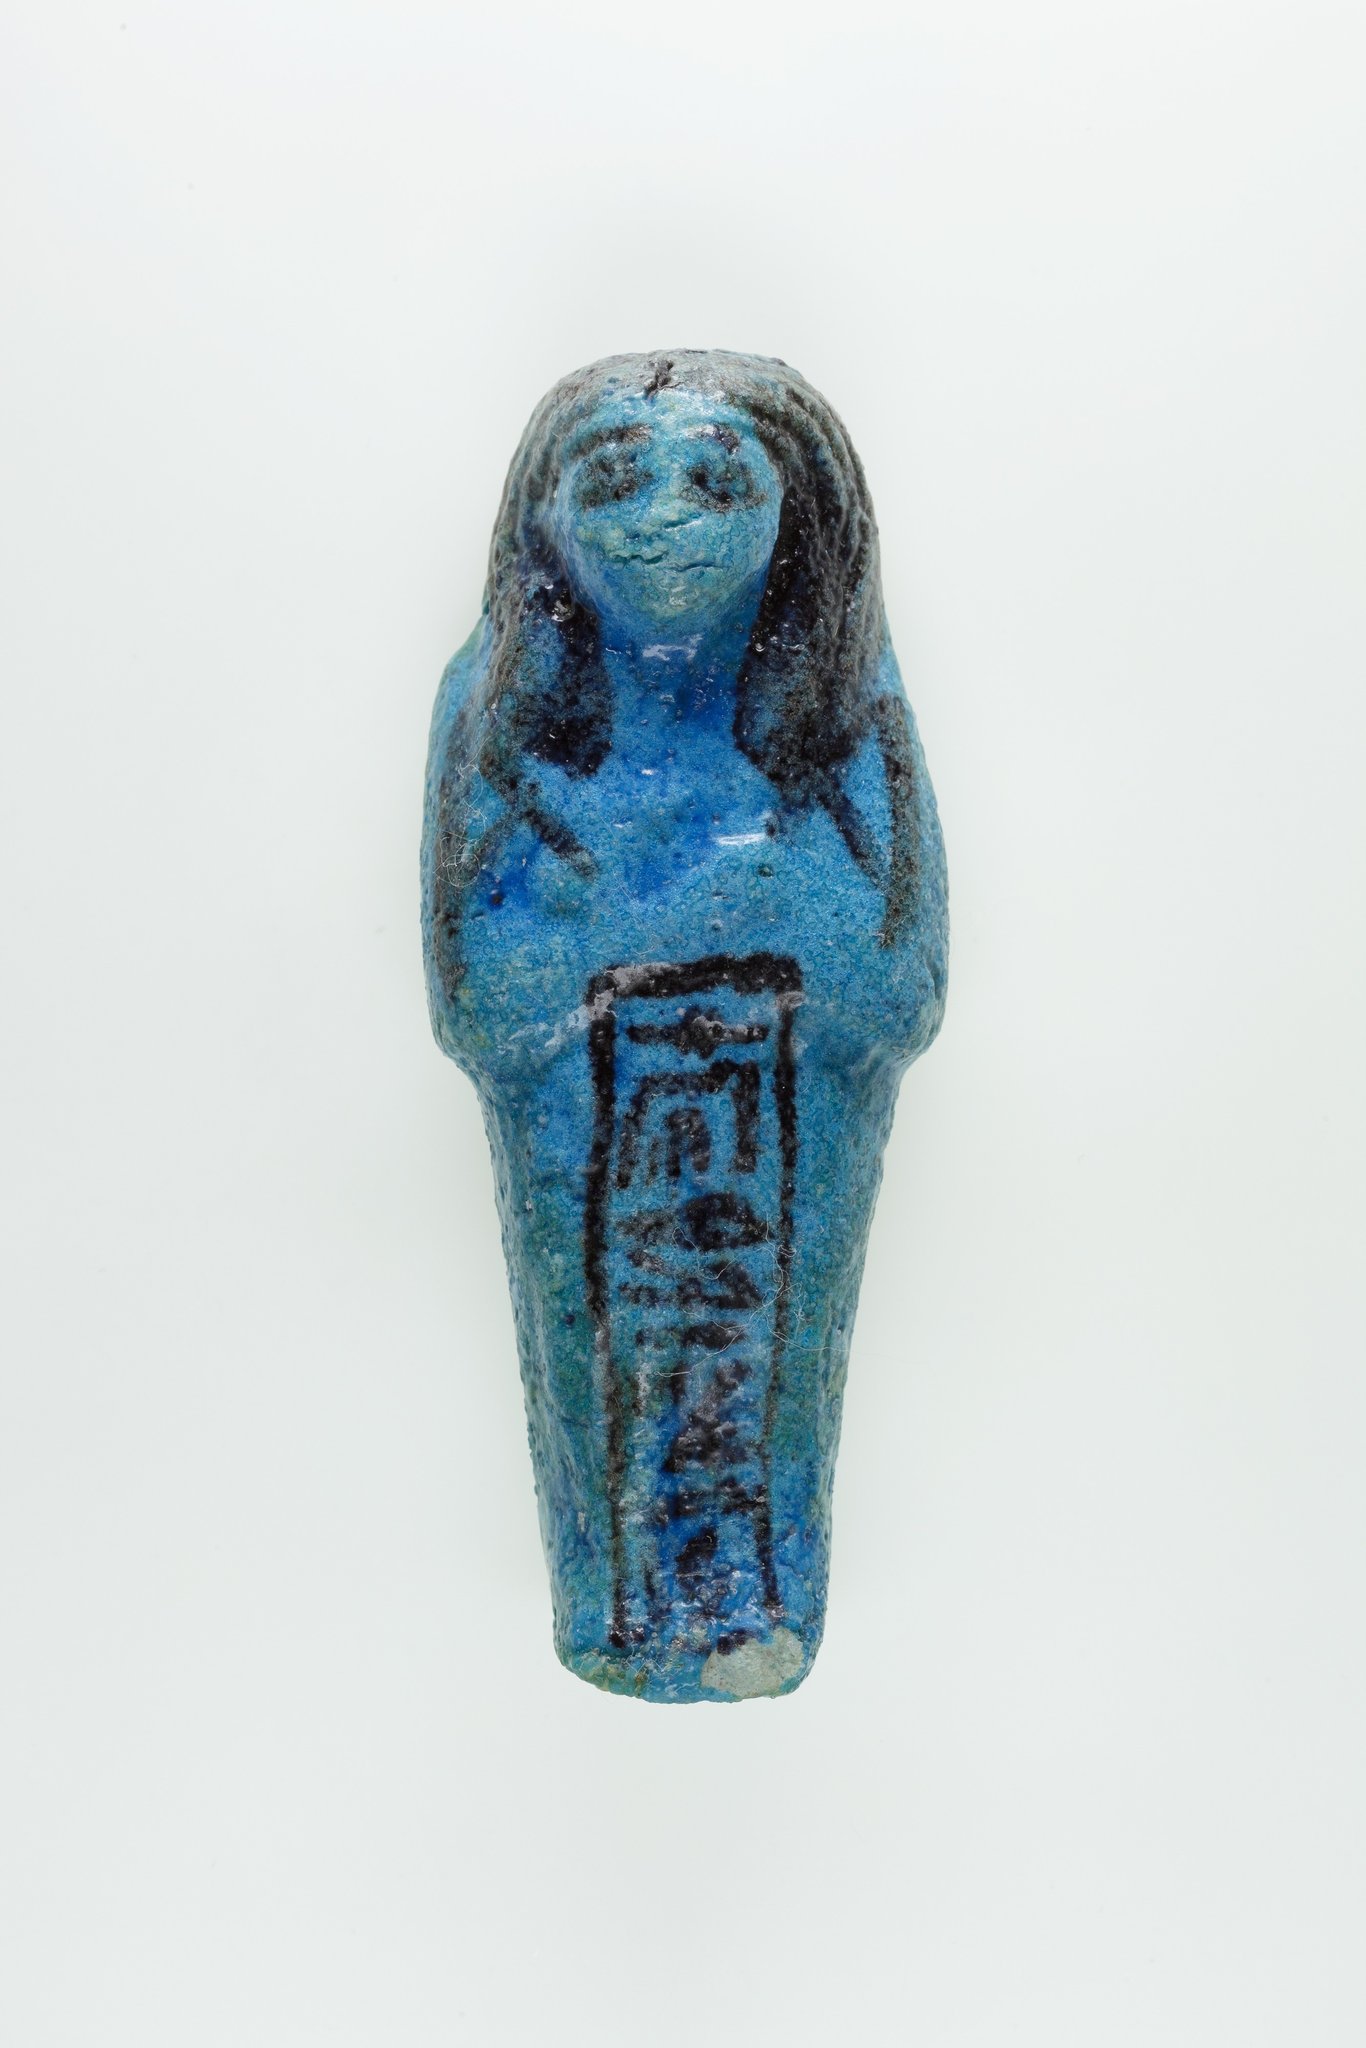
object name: shabti, worker, nauny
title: Worker Shabti of Nauny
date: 1050 BCE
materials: faience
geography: egypt